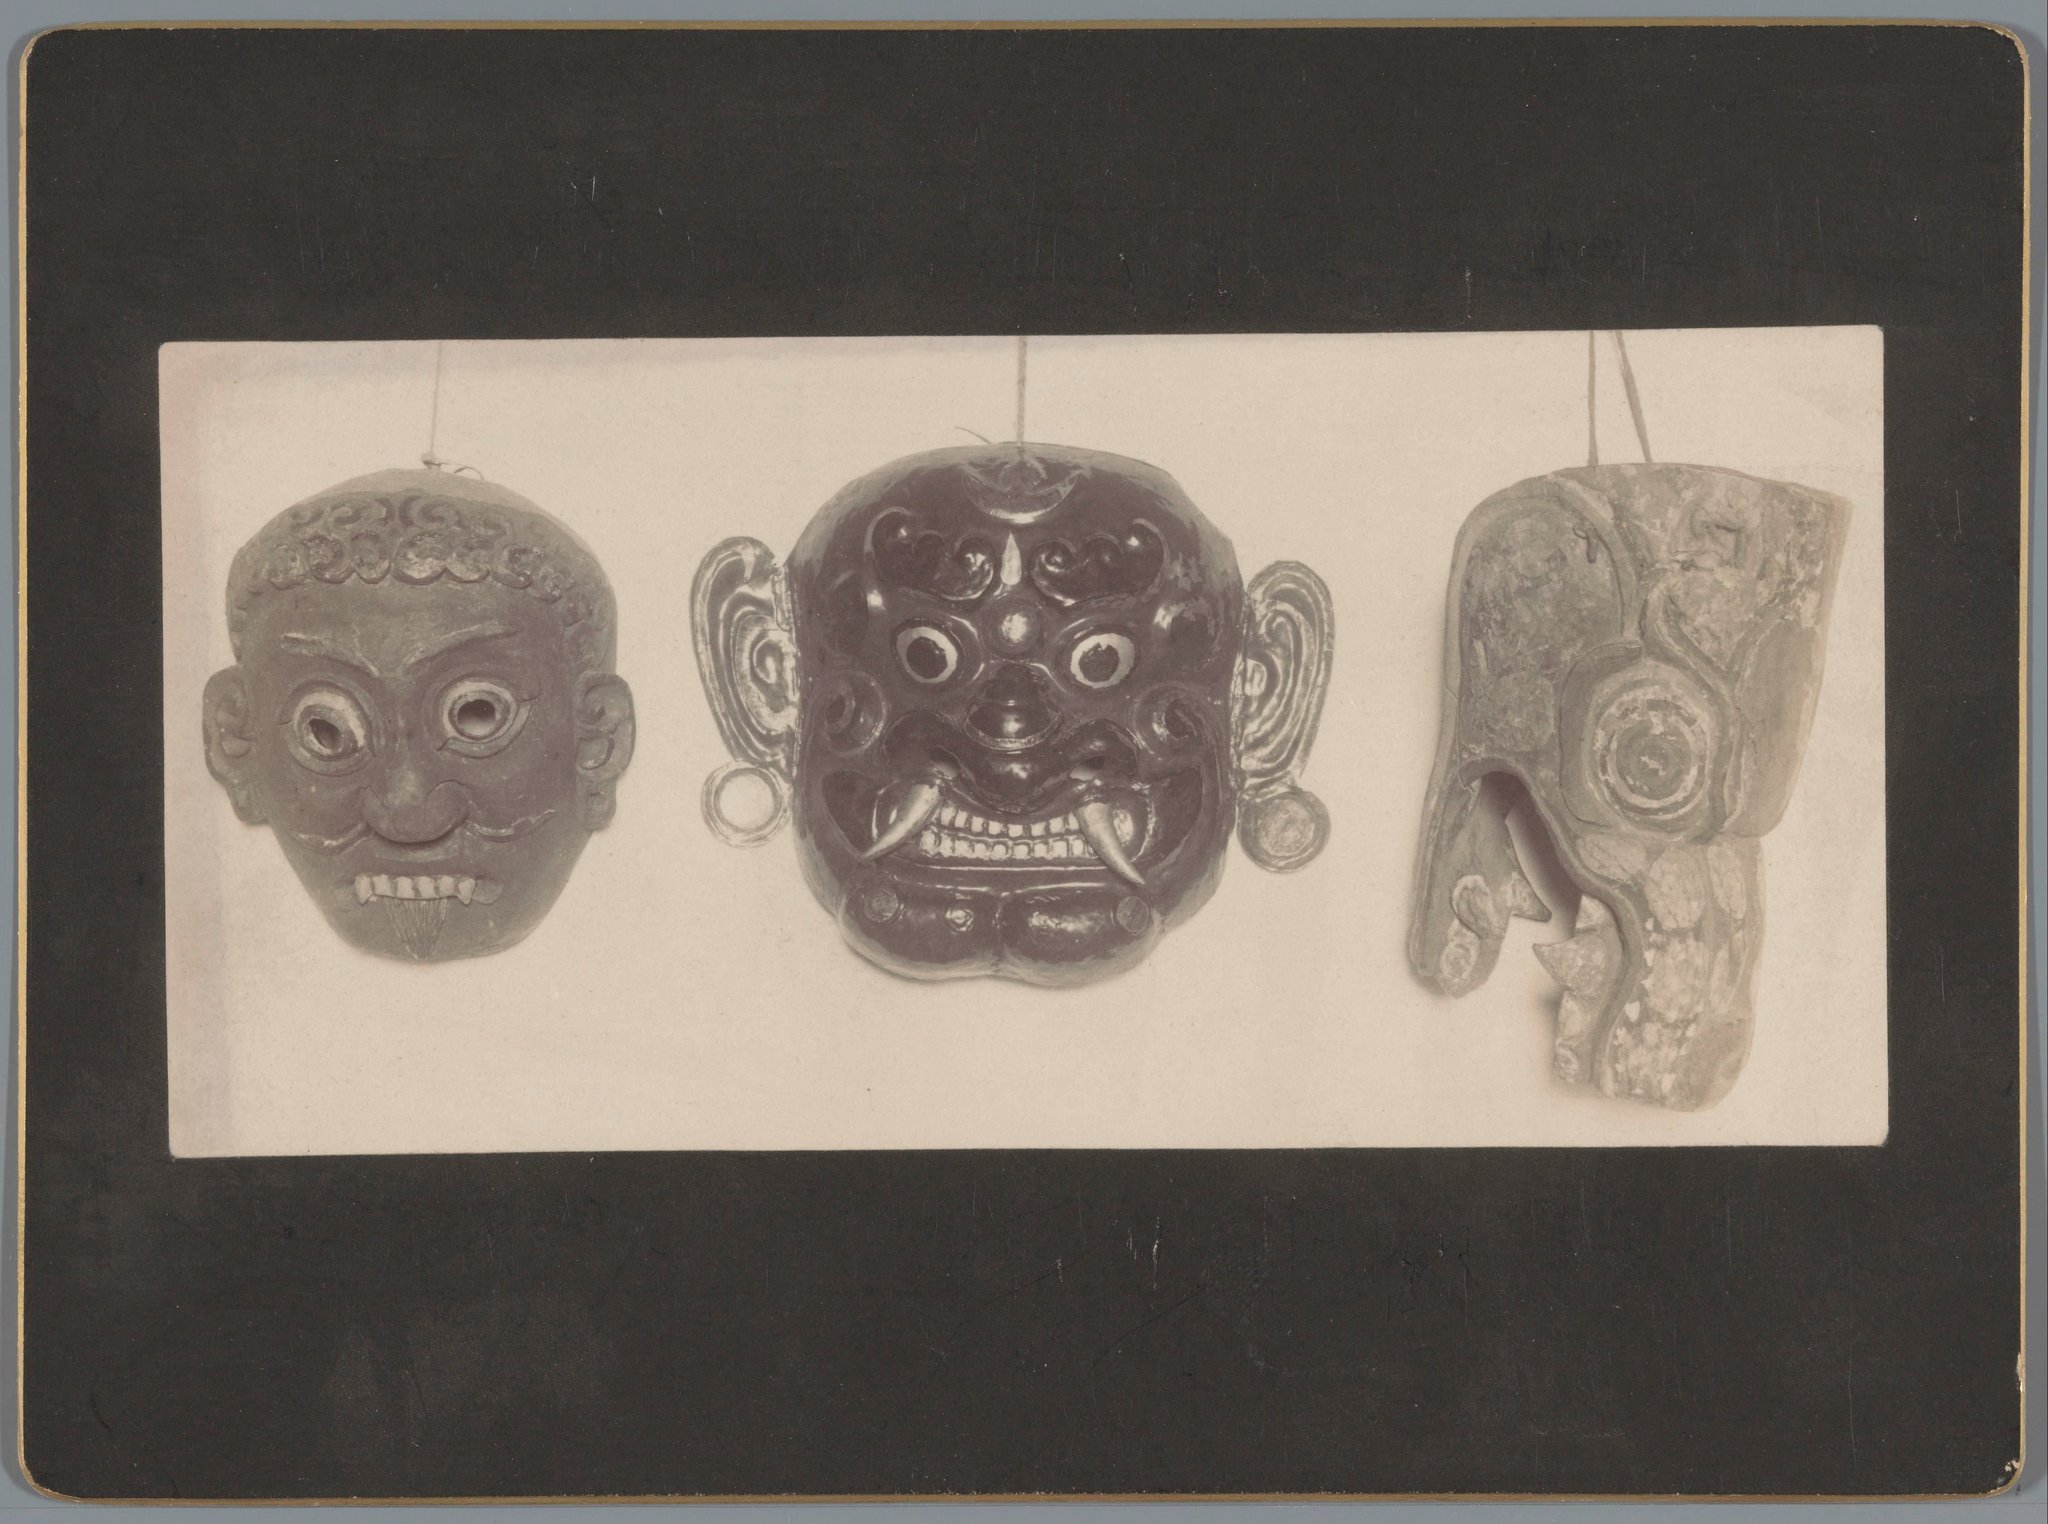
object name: photograph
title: Maskers voor den duivelsdans, Thibet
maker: Anonymous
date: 1897-1910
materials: cardboard, paper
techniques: albumen print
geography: tibet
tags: mask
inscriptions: inscription: ‘hout/ N42/ koper/ N48/ hout/ No 43’